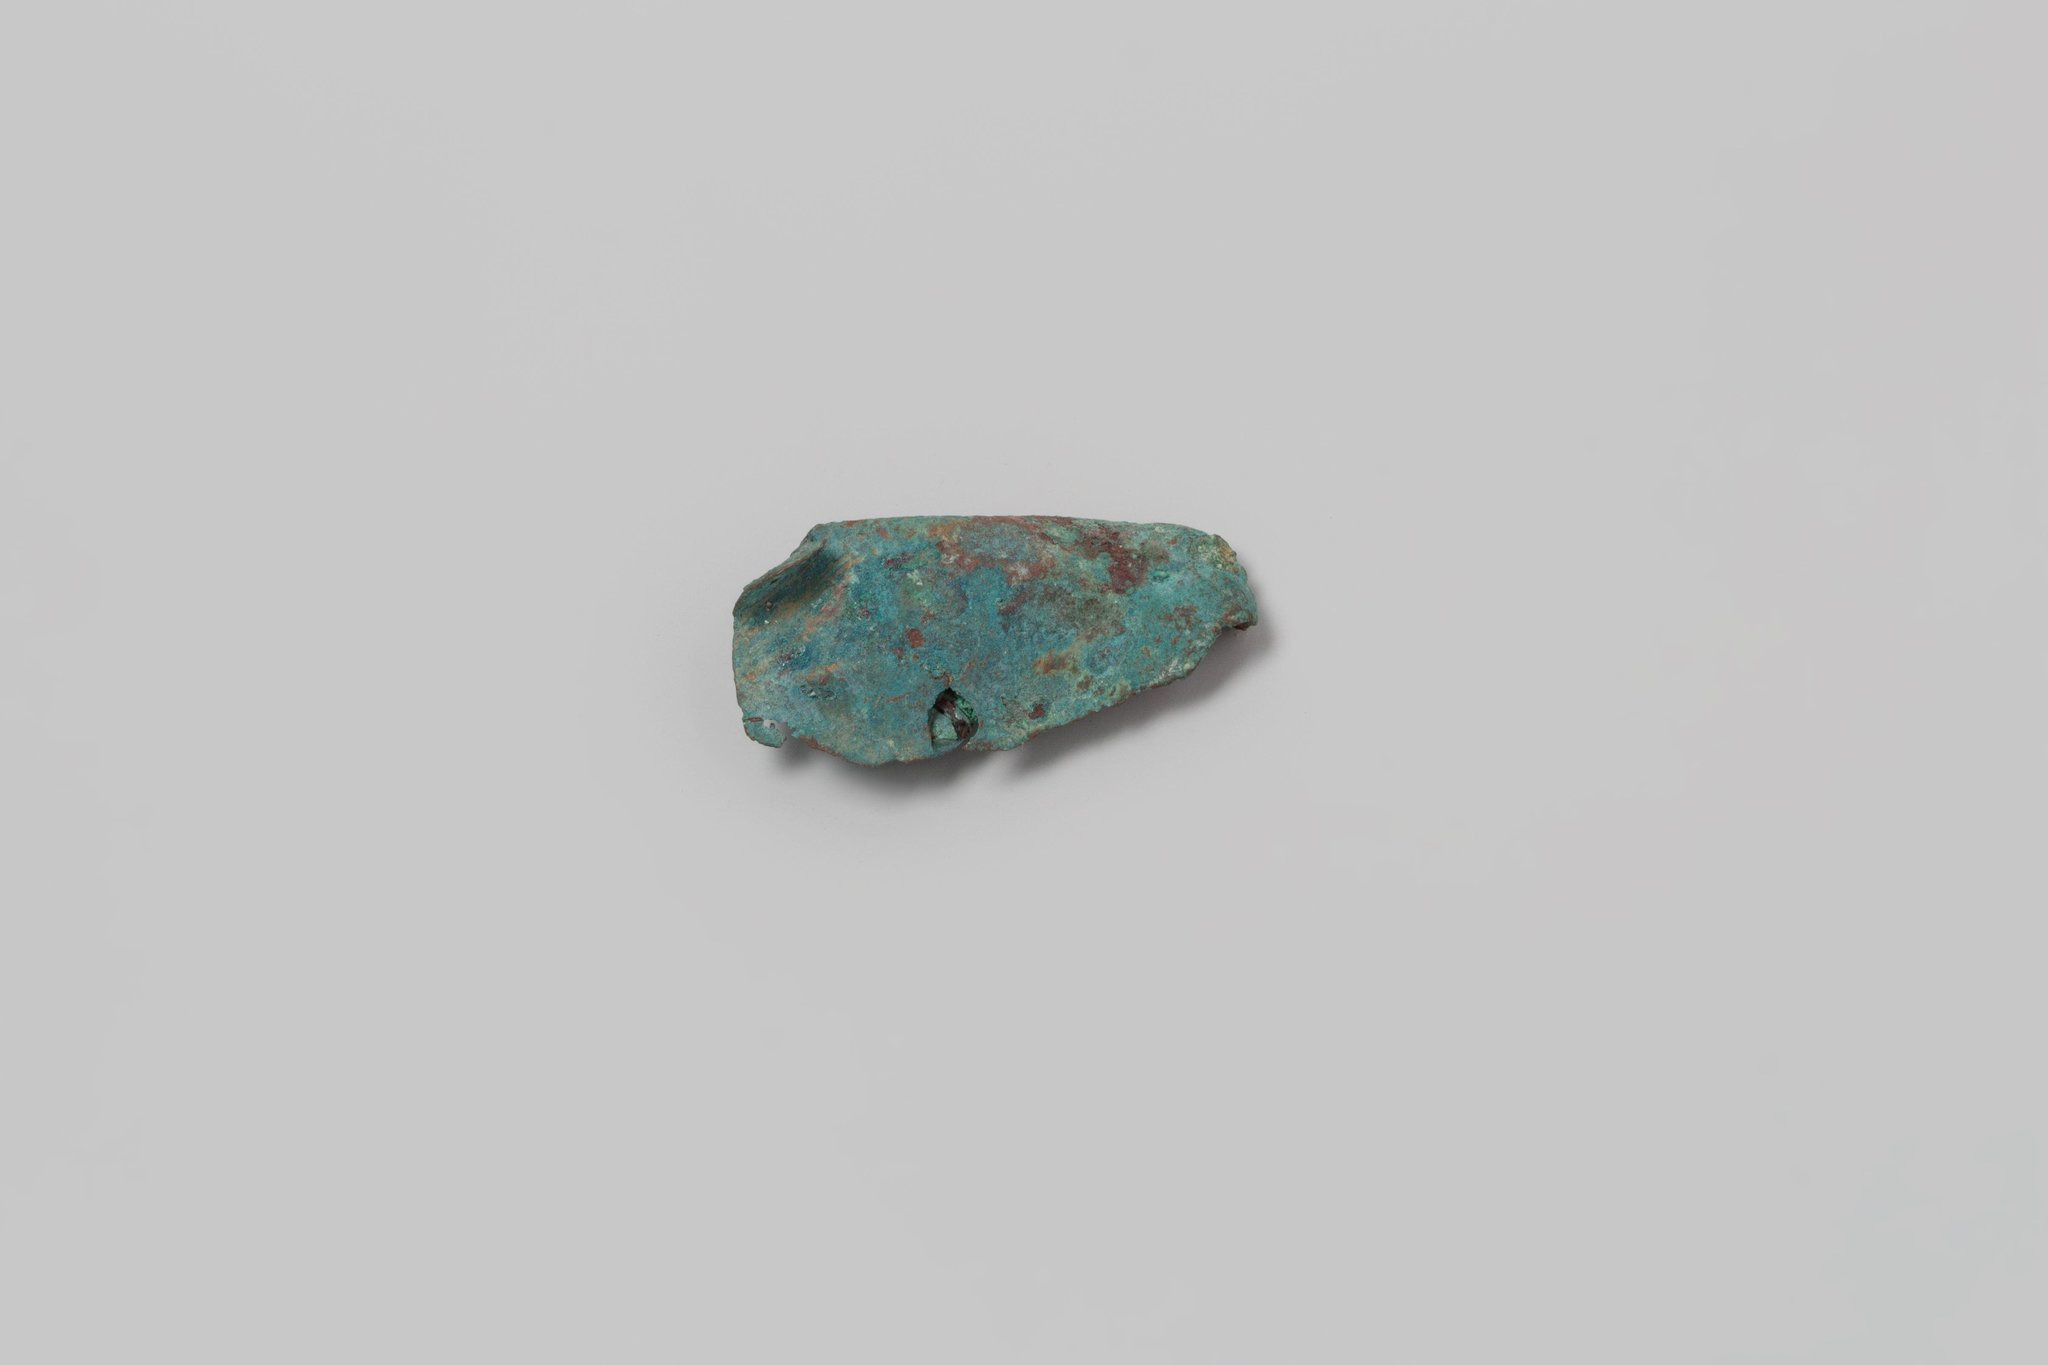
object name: fragment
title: Fragment koper uit het wrak van de Oost-Indiëvaarder Hollandia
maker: Anonymous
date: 1700-1743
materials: copper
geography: netherlands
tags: verenigde oostindische compagnie, hollandia (schip), annet